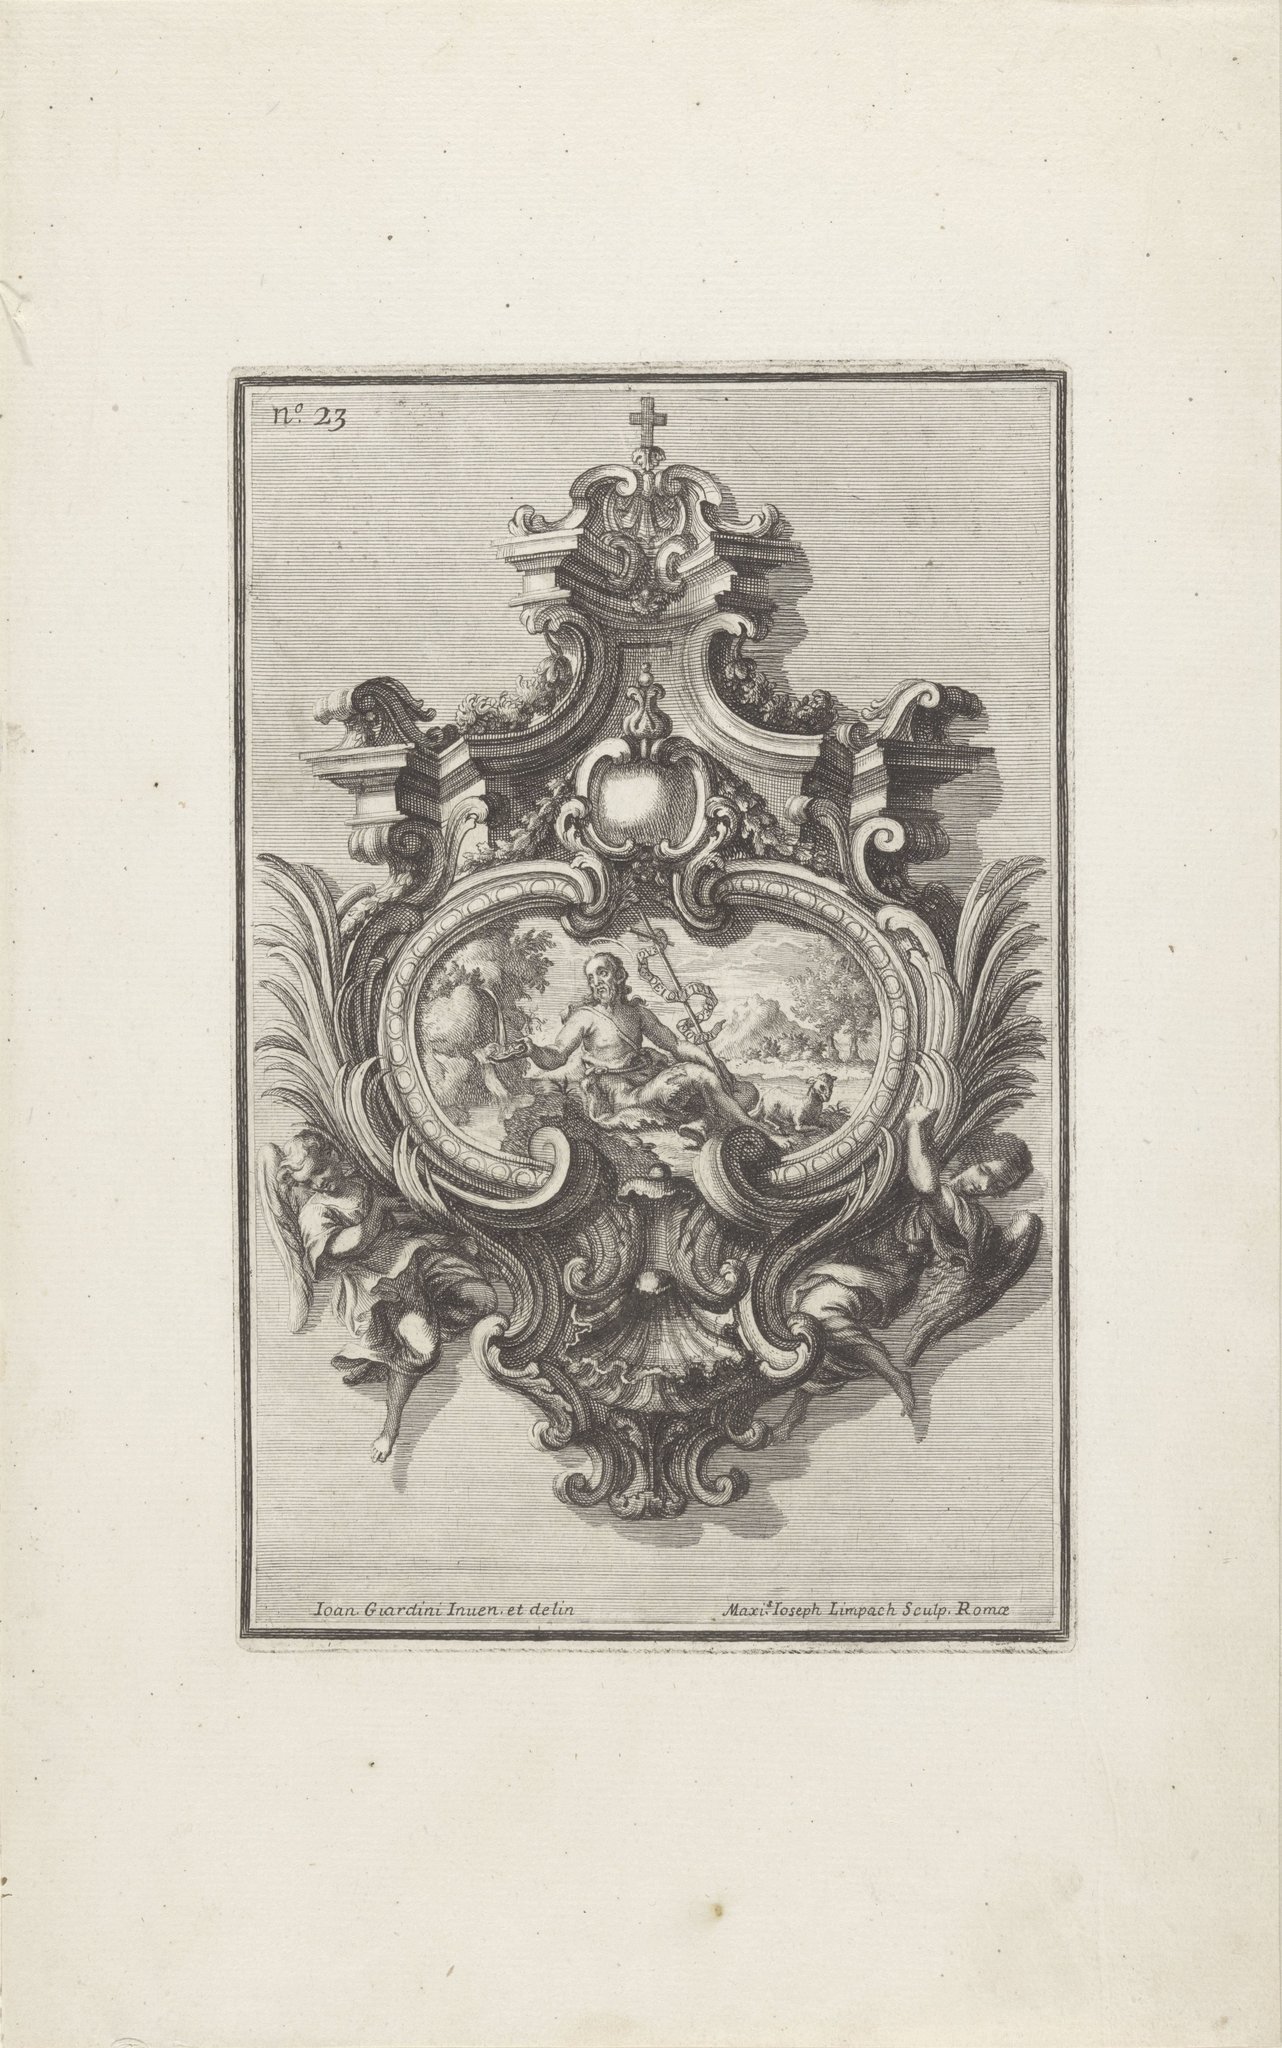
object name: print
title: Ornament met Johannes de Doper in de wildernis en twee engelen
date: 1714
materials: paper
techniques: etching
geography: vatican city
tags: ornaments ~ art, series of scenes from the life of john the baptist, angels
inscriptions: collector's mark: Lugt 2228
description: Prent maakt deel uit van een reeks van 100 ornamentprenten naar ontwerp van Giovanni Giardini.